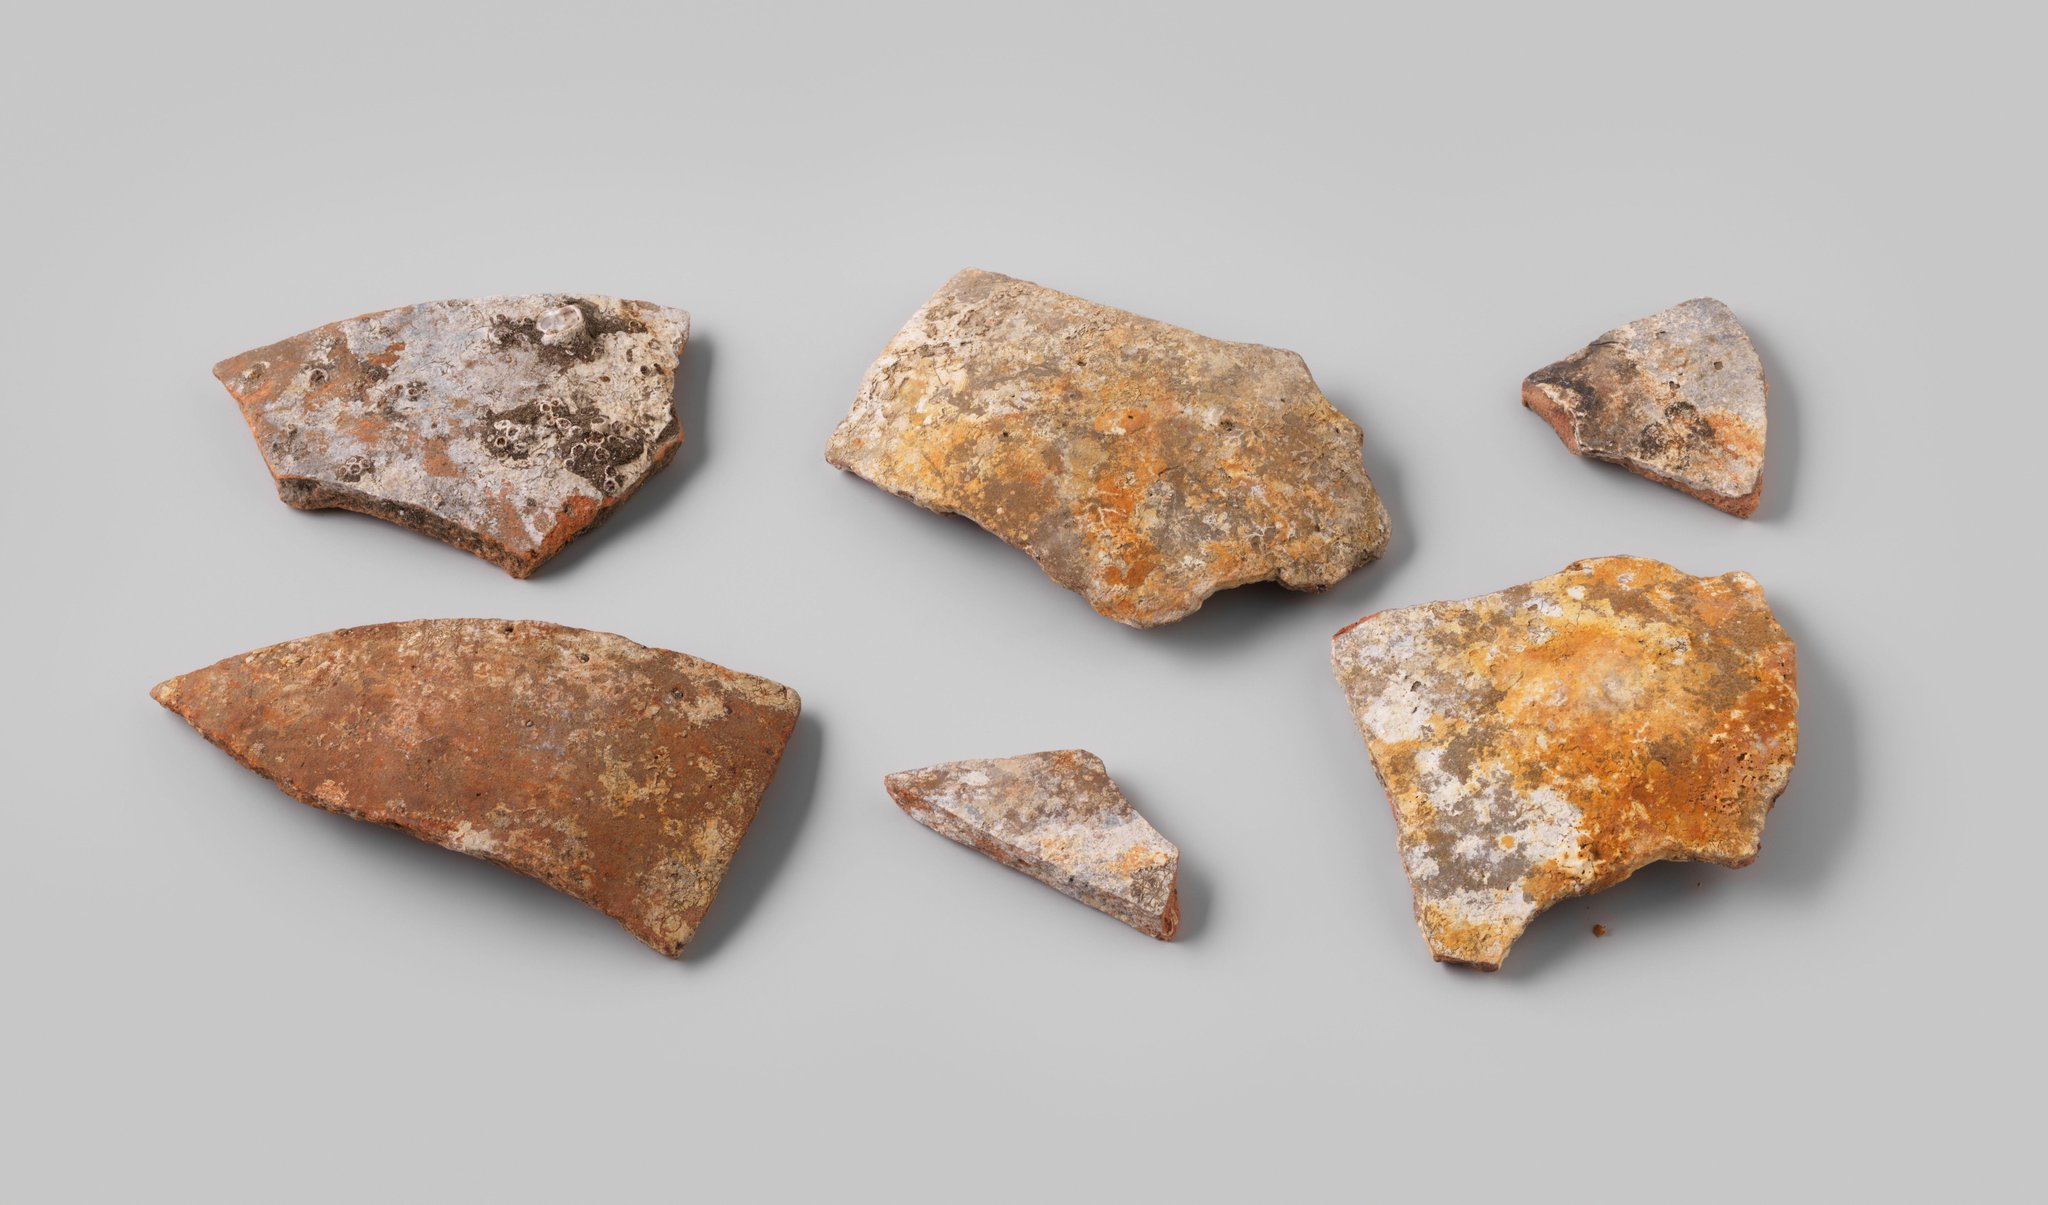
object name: martavaan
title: Scherven van martavanen uit het wrak van de Oostindiëvaarder Hollandia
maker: Anonymous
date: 1700-1743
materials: porcelain, stoneware